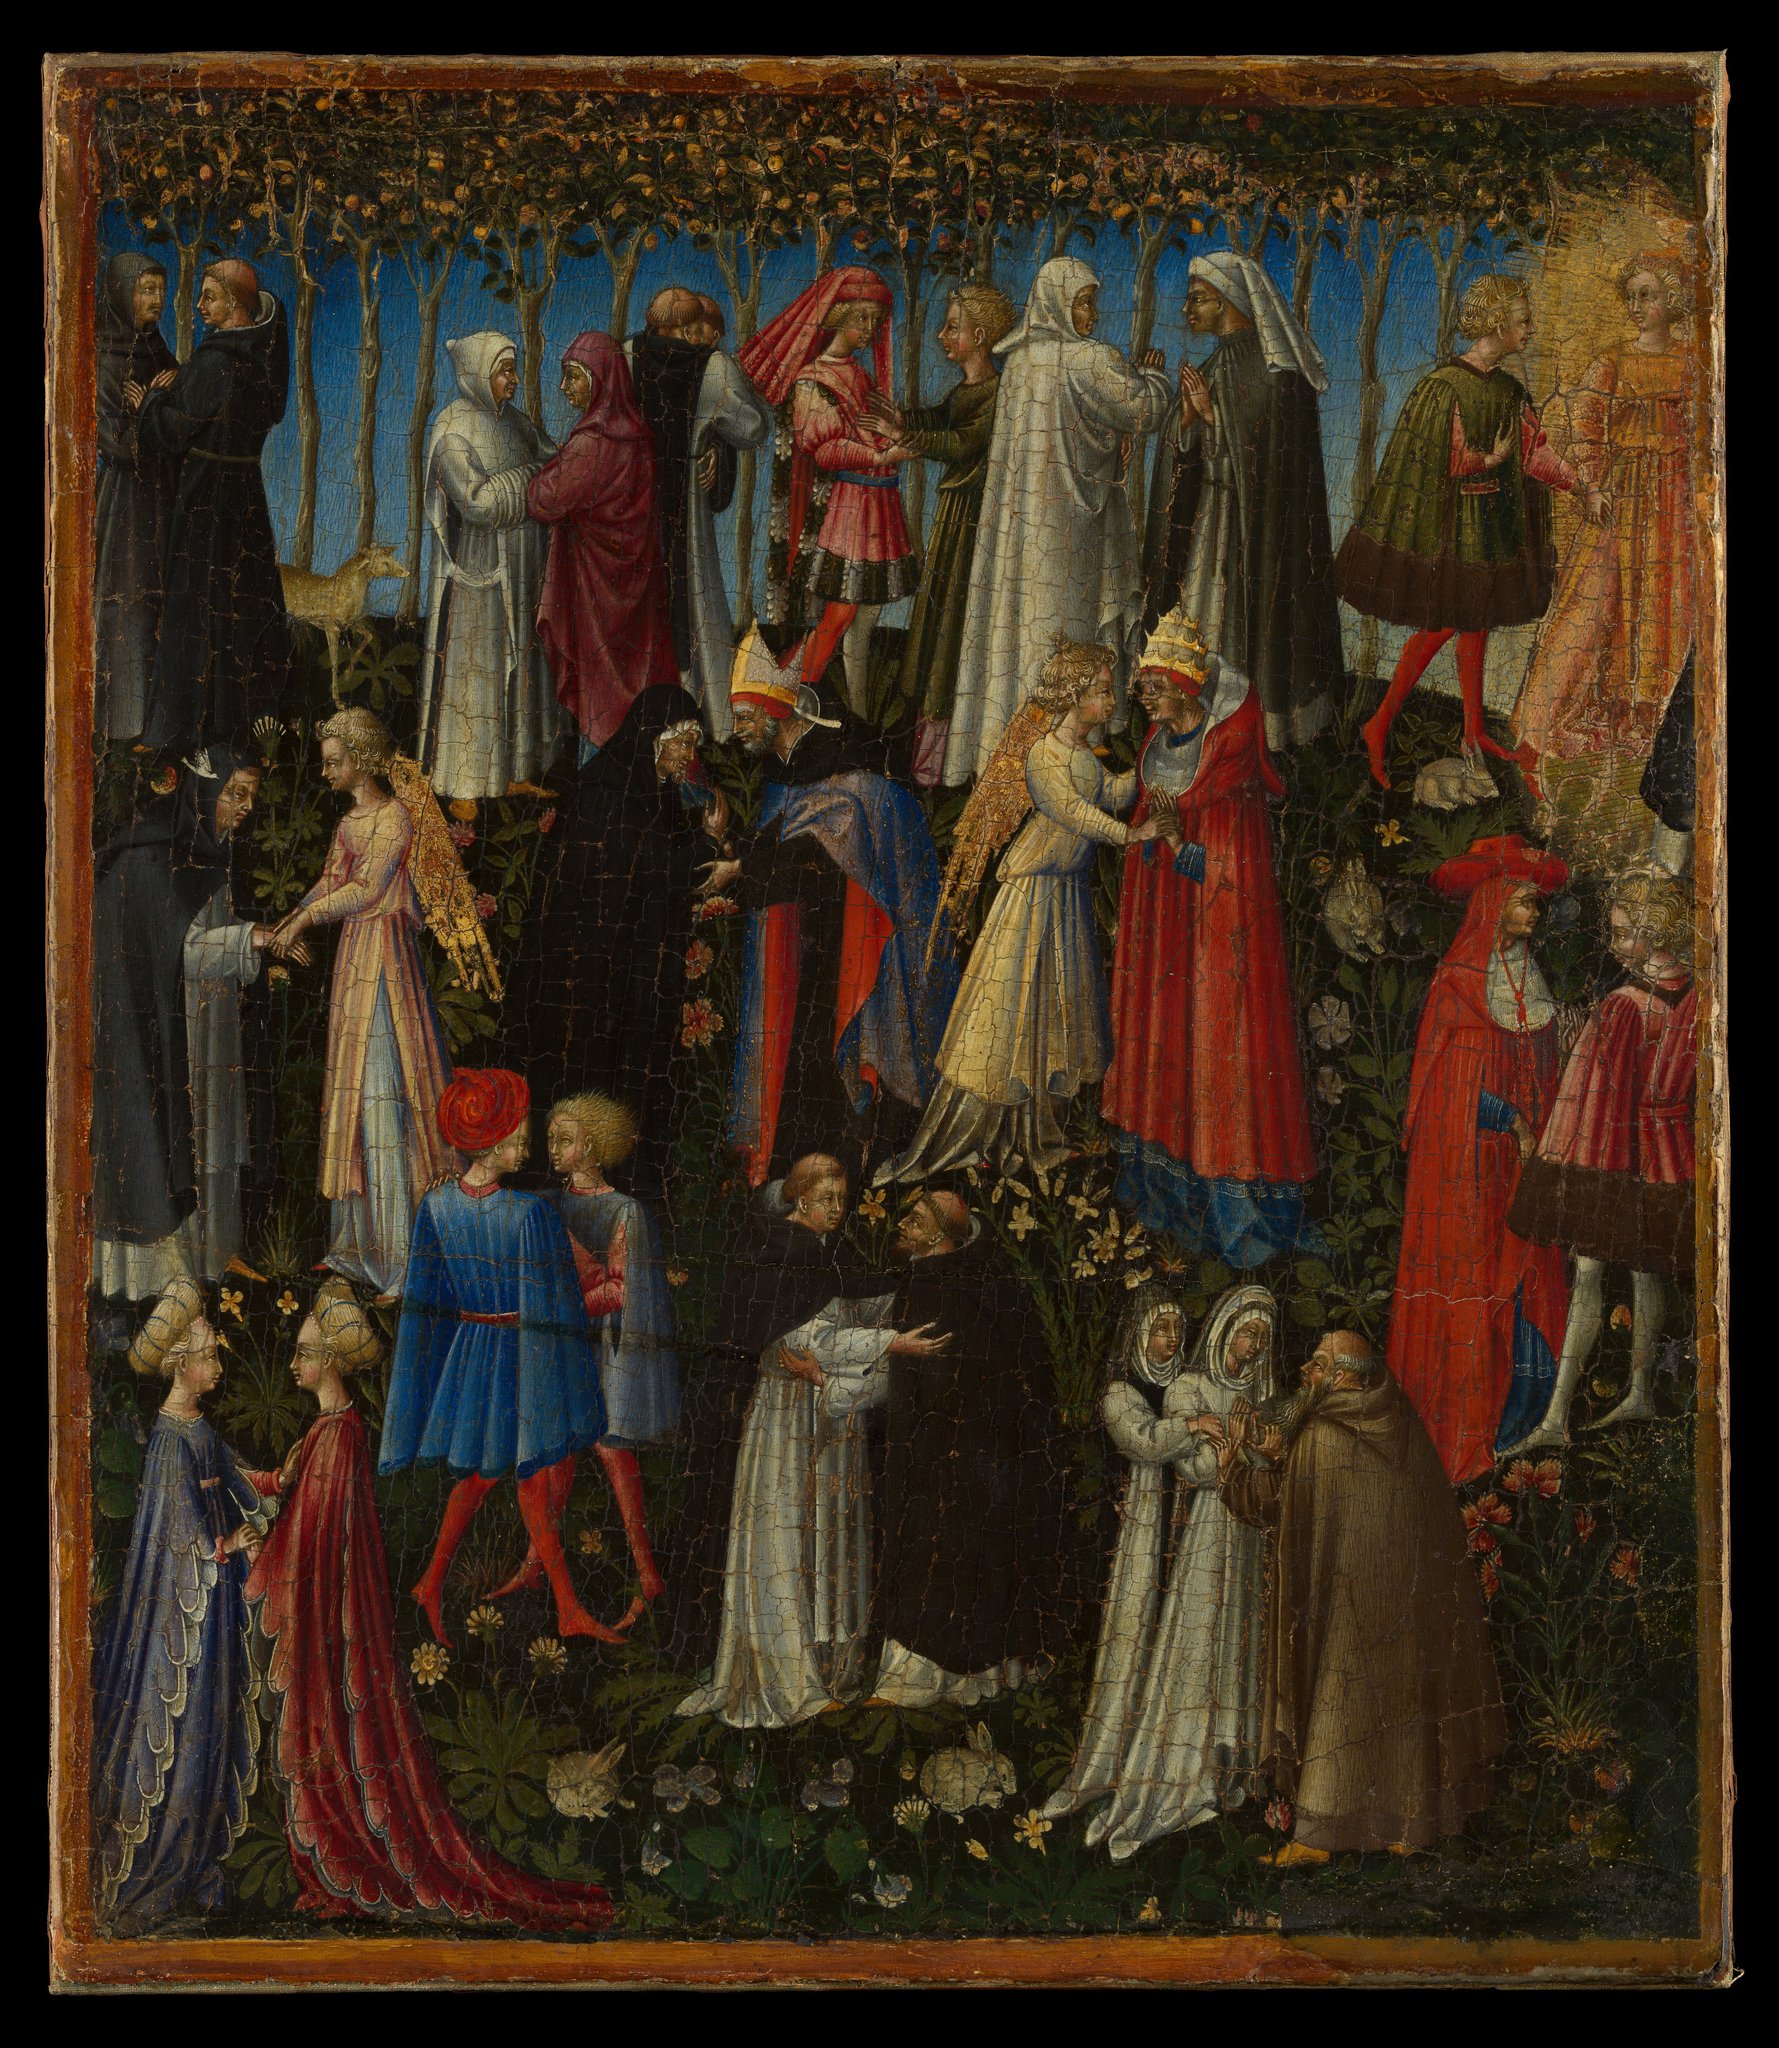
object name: painting, predella panel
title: Paradise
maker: giovanni di paolo (giovanni di paolo di grazia)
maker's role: artist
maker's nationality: italian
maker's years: 1398-1482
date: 1445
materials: canvas, gold, paint, wood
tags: gardens,men,women,rabbits,angels,saints